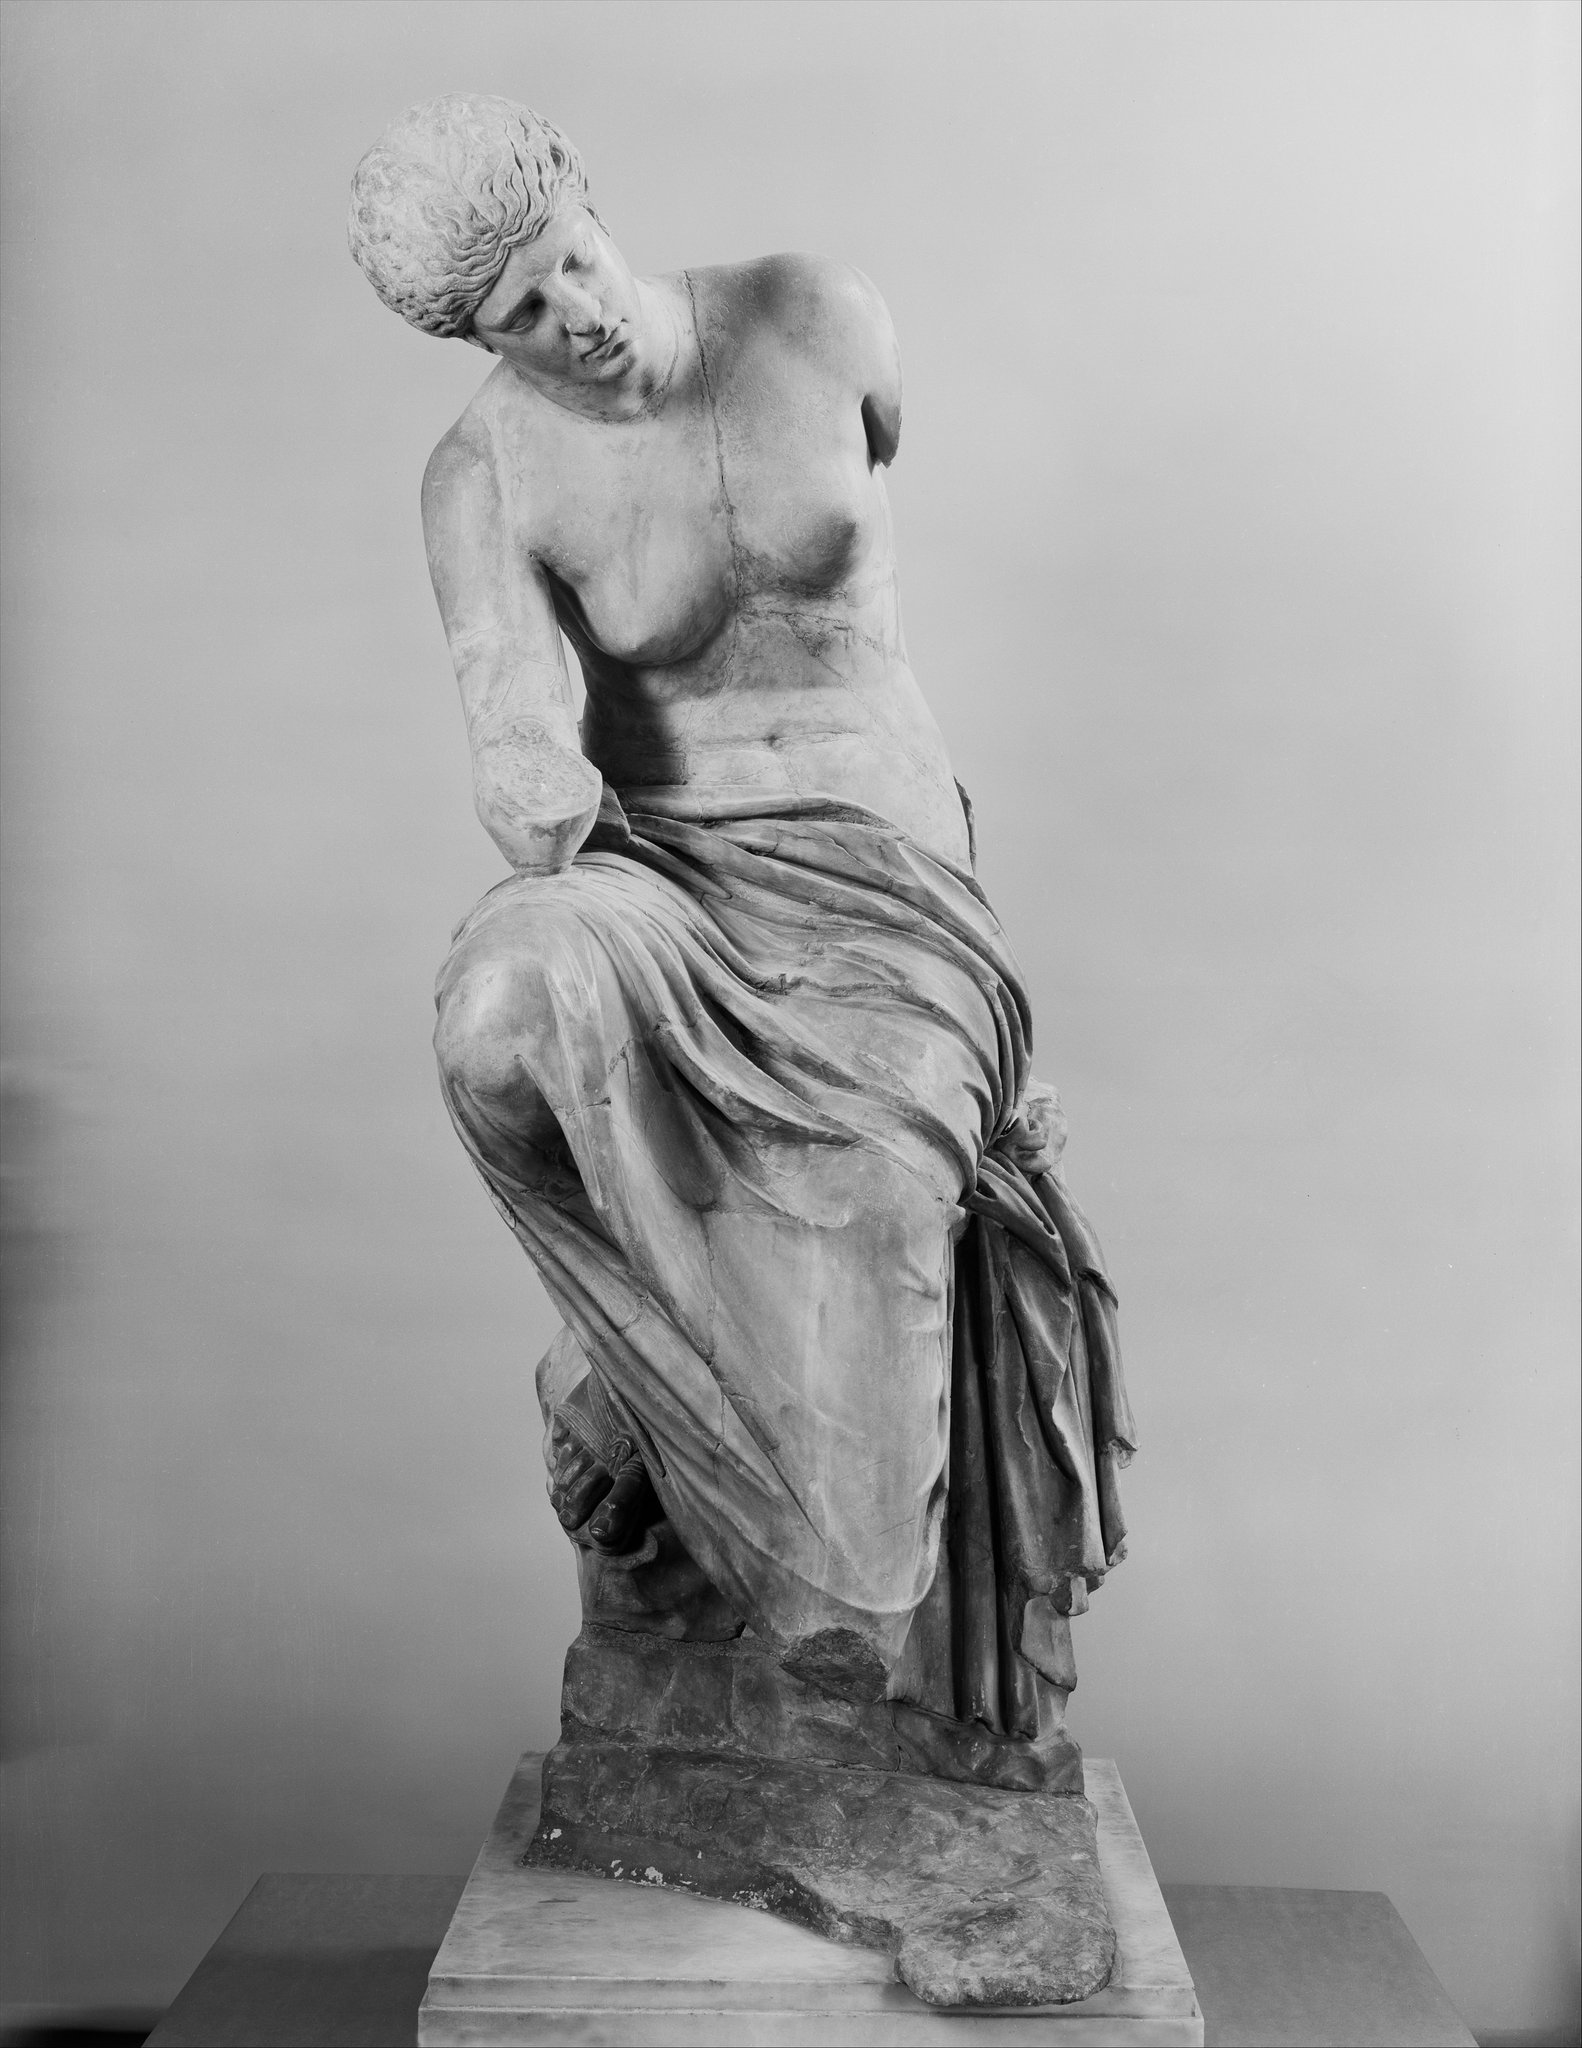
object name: statue of a woman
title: Marble statue of a seated muse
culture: roman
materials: marble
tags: female nudes